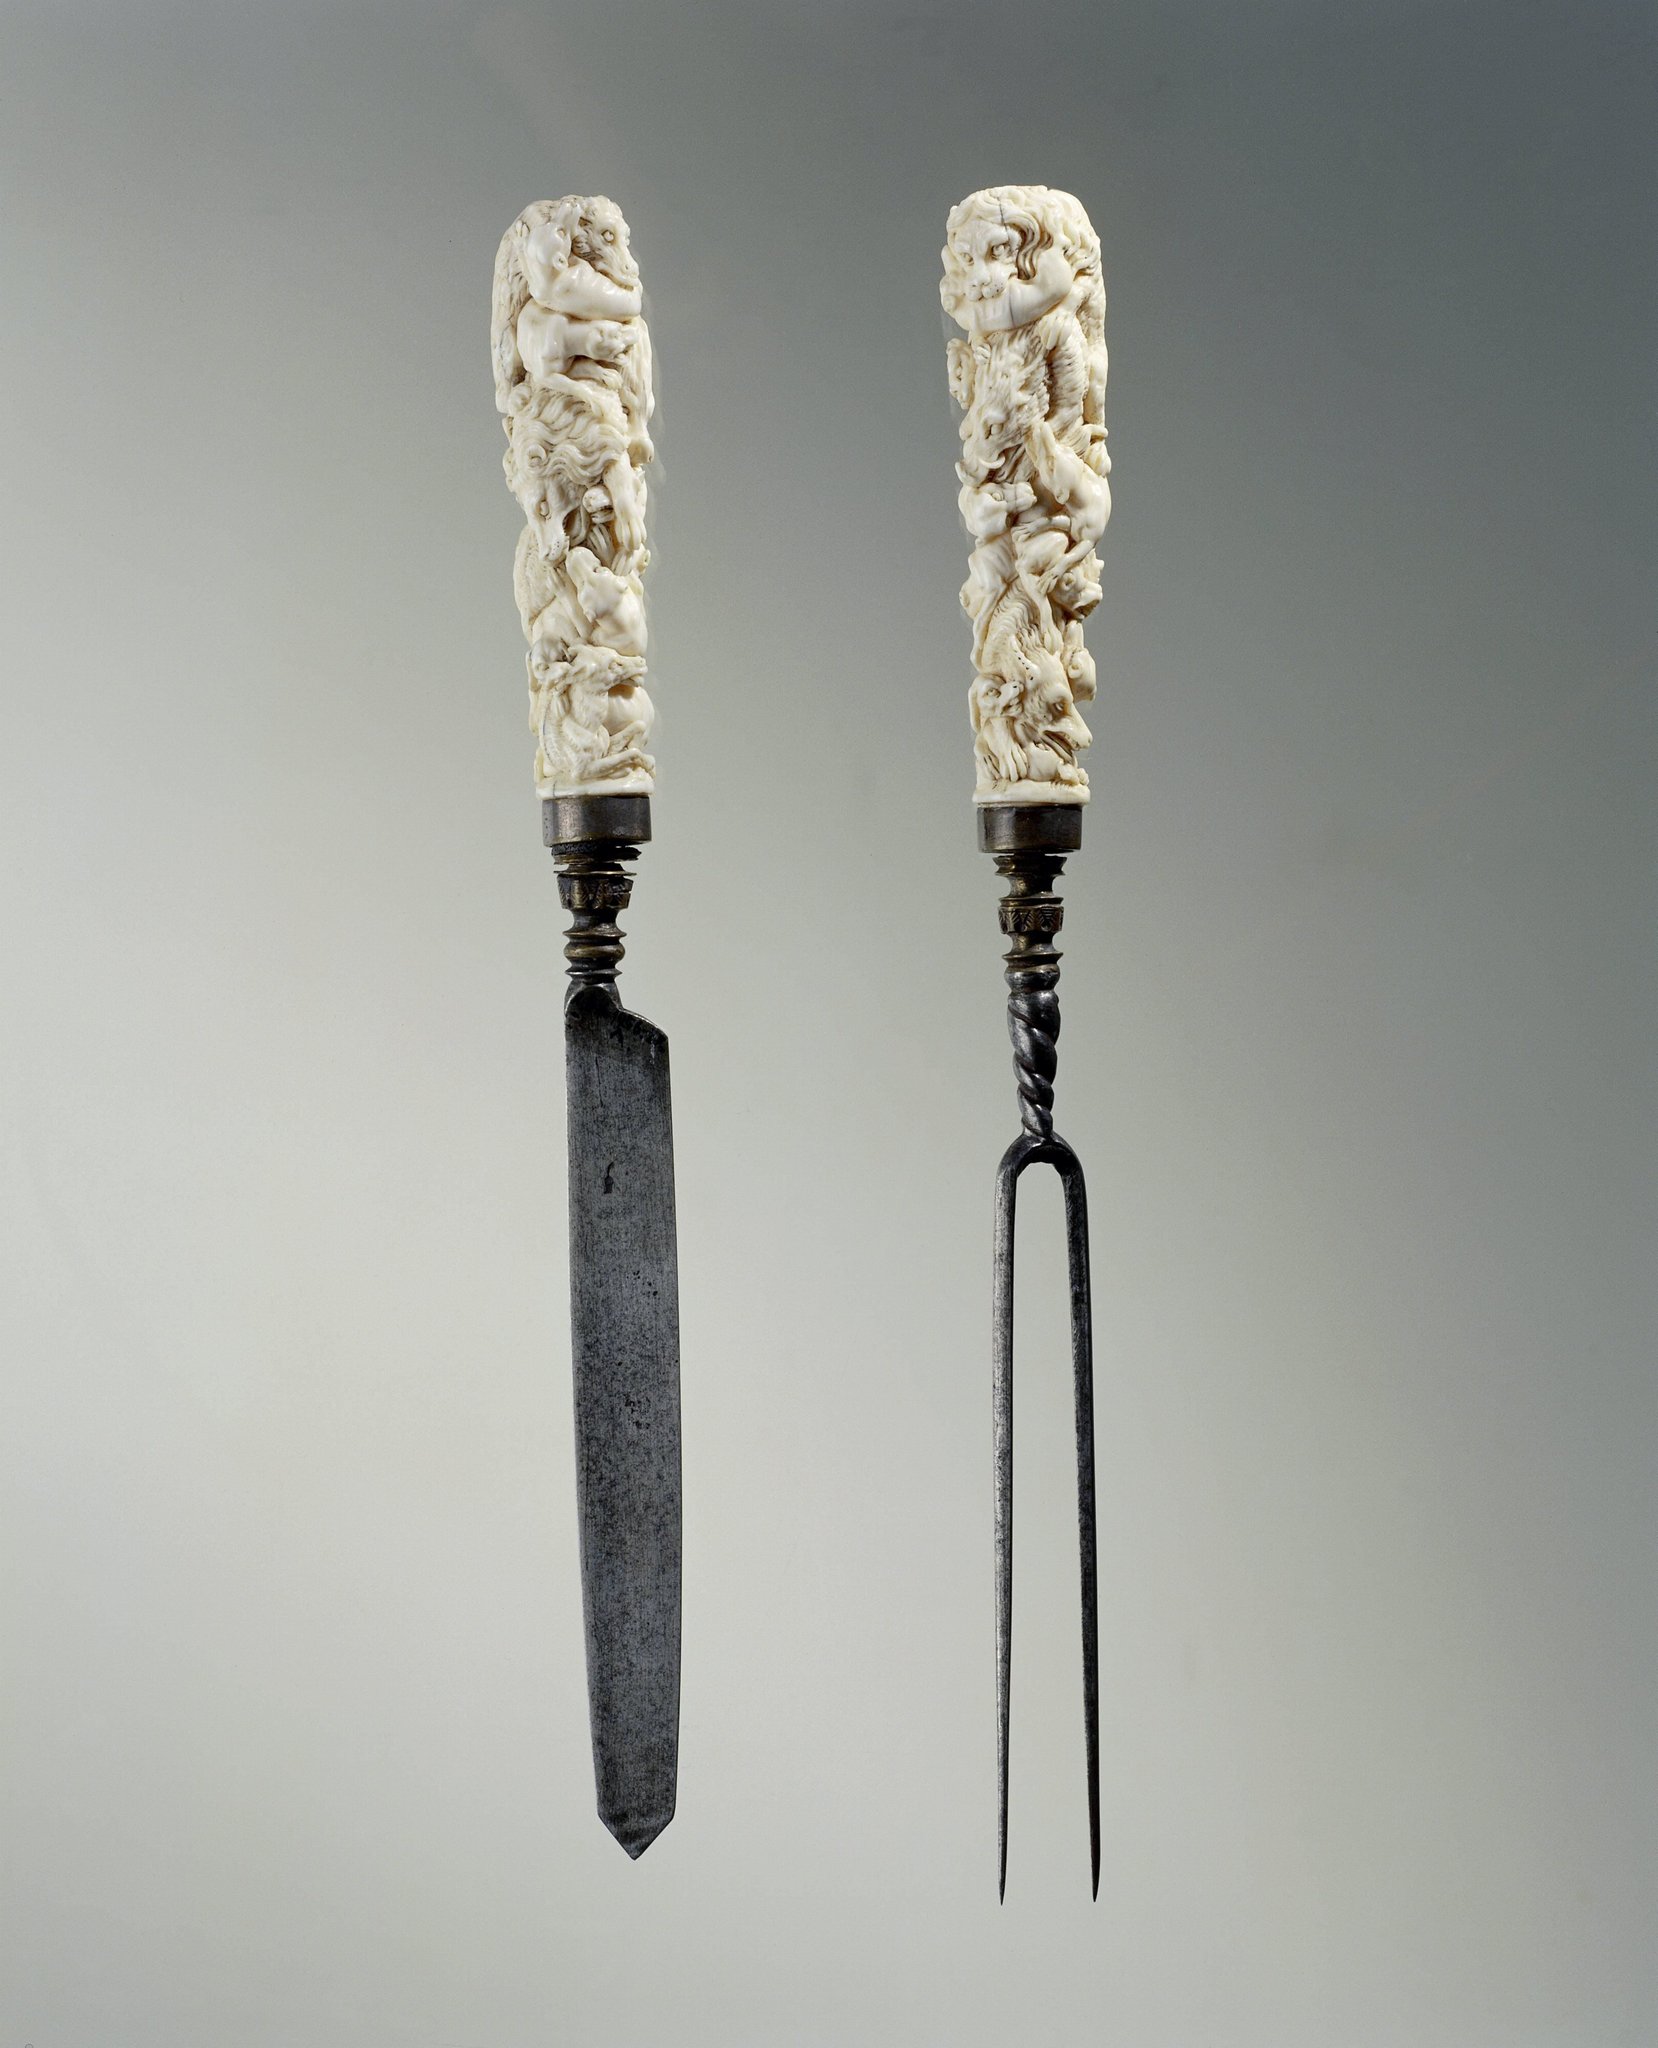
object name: fork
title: Vork met een heft van vechtende dieren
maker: Anonymous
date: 1675-1725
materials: ivory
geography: germany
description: Hunting knife and fork. Ivory and steel. Germany, c. 1670.